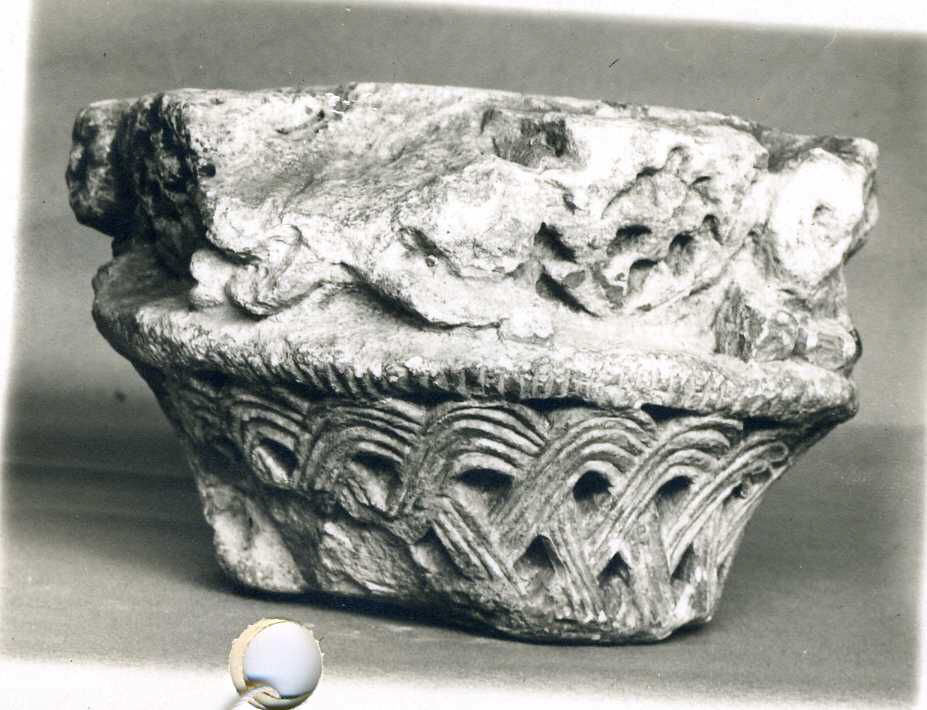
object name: capital fragment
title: Fragment of a Capital with a Basket-Weave Pattern and Crosses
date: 501-700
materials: limestone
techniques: carving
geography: egypt